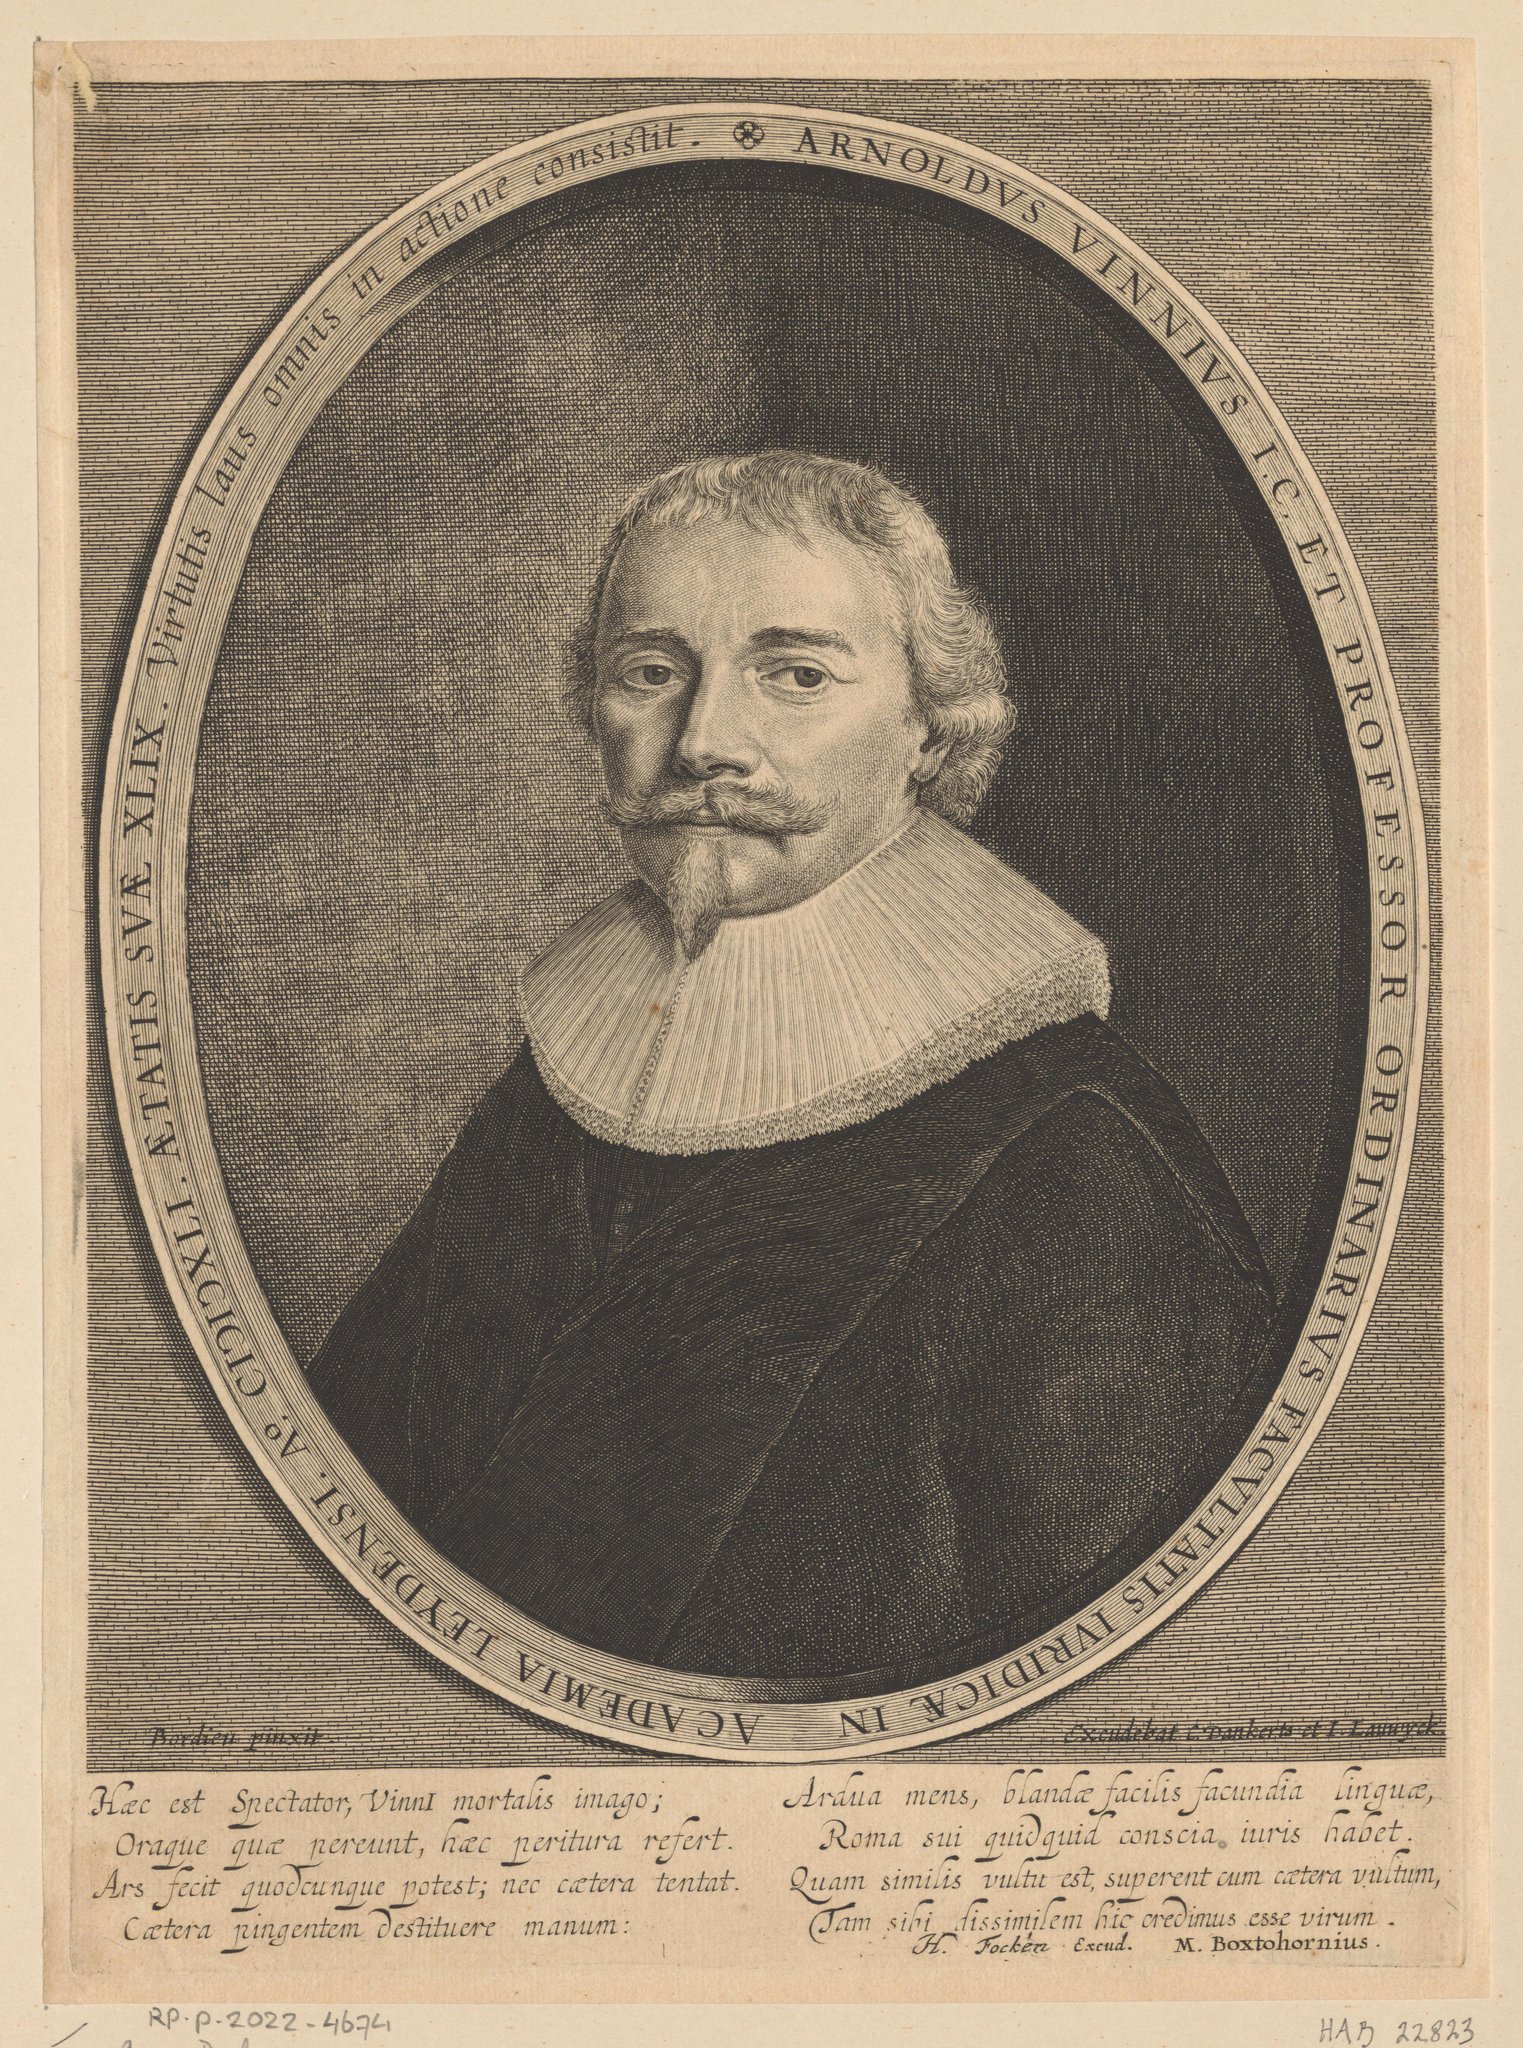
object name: print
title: Portret van Arnoldus Vinnius op 49-jarige leeftijd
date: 1665-1689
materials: paper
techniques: engraving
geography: leiden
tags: scholar, philosopher, historical persons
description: Met achtregelig onderschrift in het Latijn.